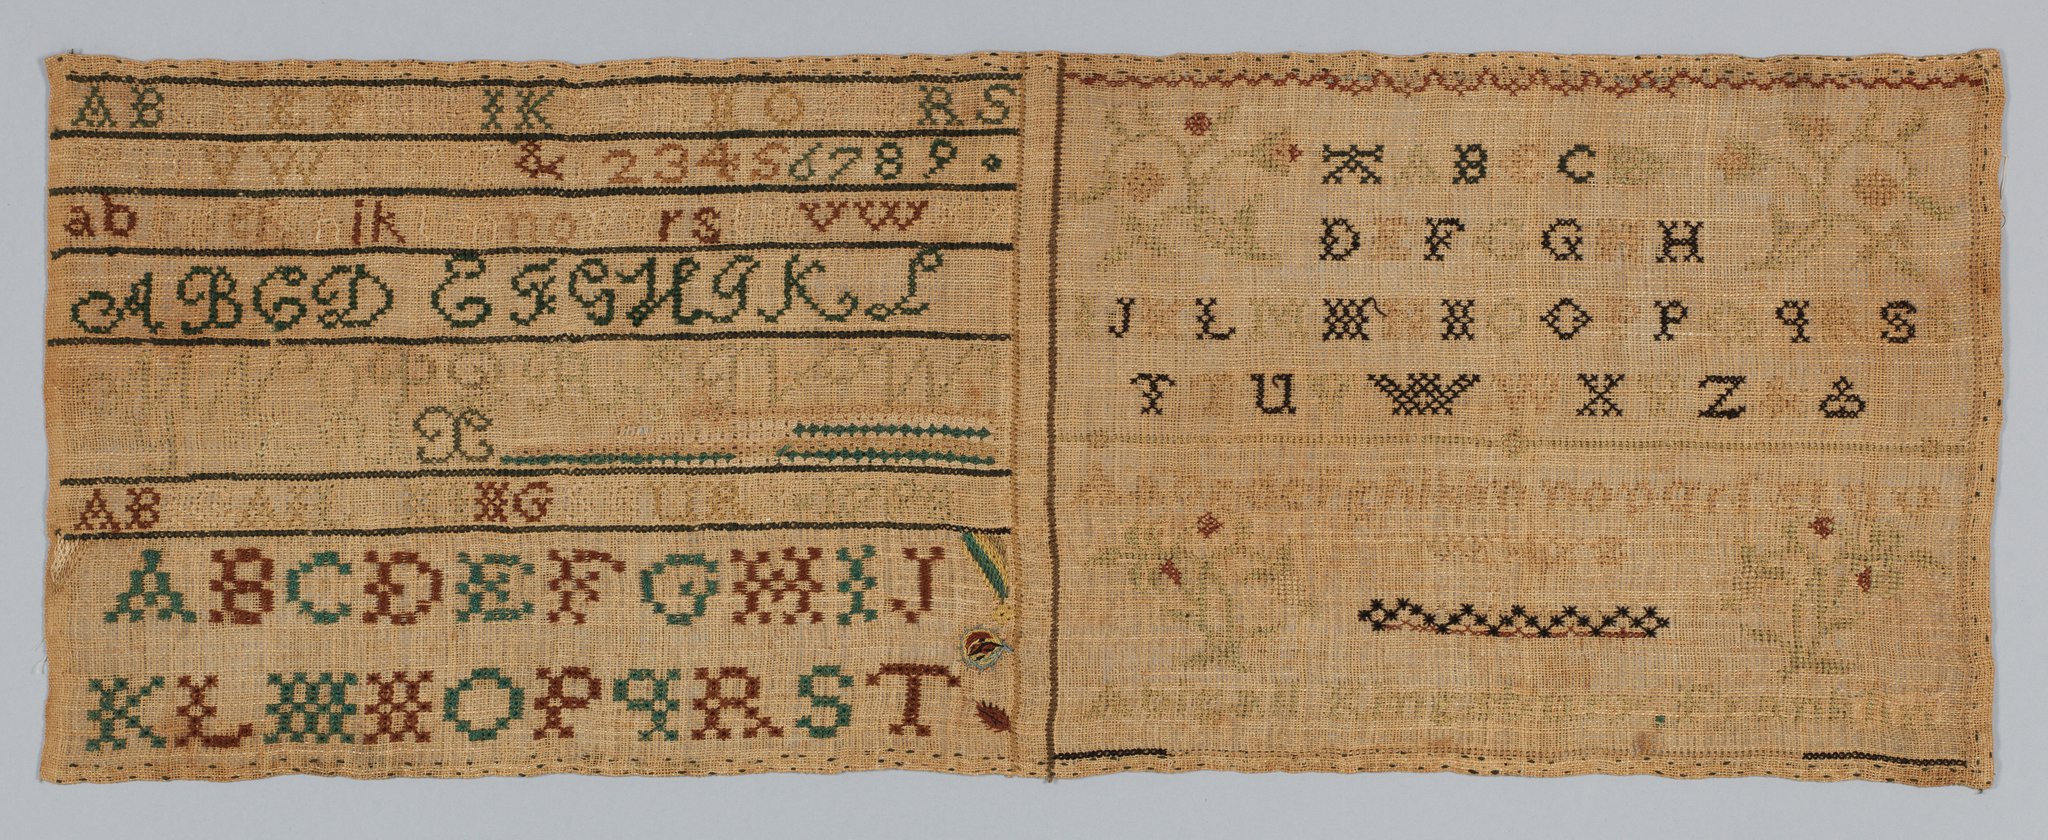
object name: sampler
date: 1701-1800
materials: canvas, linen, silk